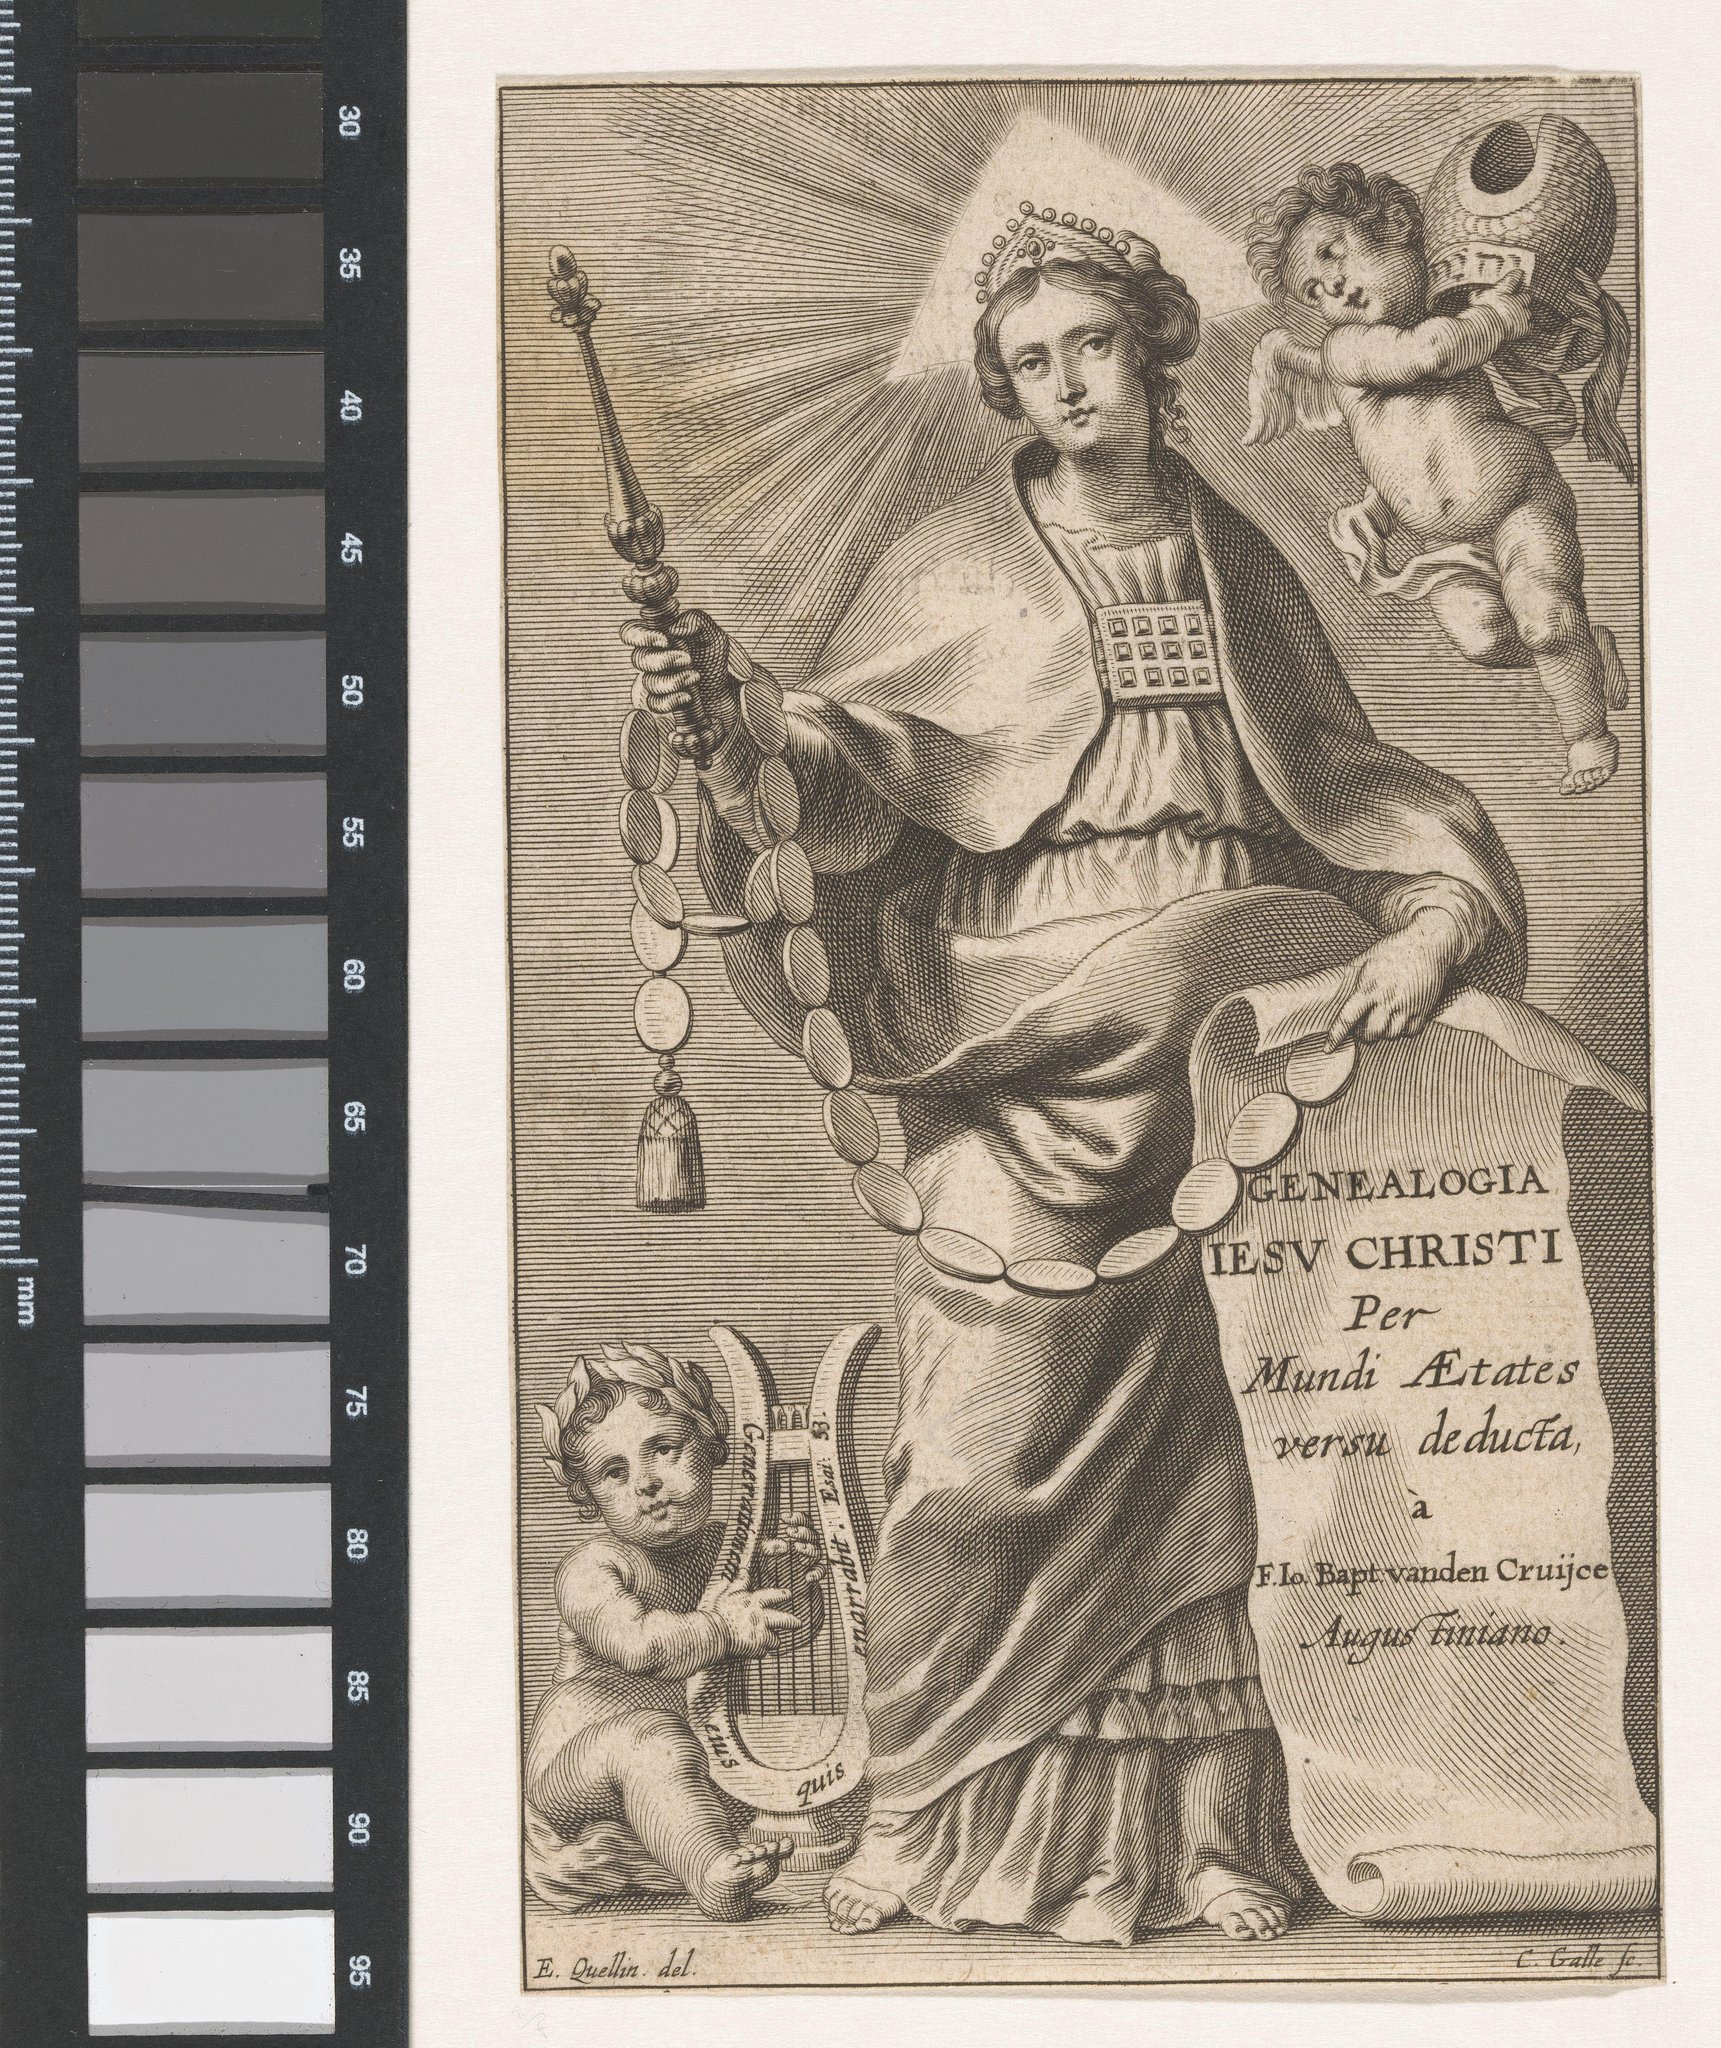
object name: print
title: Staande vrouw met scepter en kroon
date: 1654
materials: paper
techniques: engraving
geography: southern netherlands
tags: harp, head-gear of high priest ~ jewish religion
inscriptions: collector's mark: Lugt 2228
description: Staande vrouw met kroon en scepter. In haar linker hand houdt ze een boekrol met de titel van het boek. Rechtsboven een vliegende engel met de hoed van een hoge priester. Op de grond zit een tweede engel op een lier te spelen. Titelpagina voor een boek met Latijnse gedichten over de familierelaties tussen personen uit het Oude Testament en Christus.